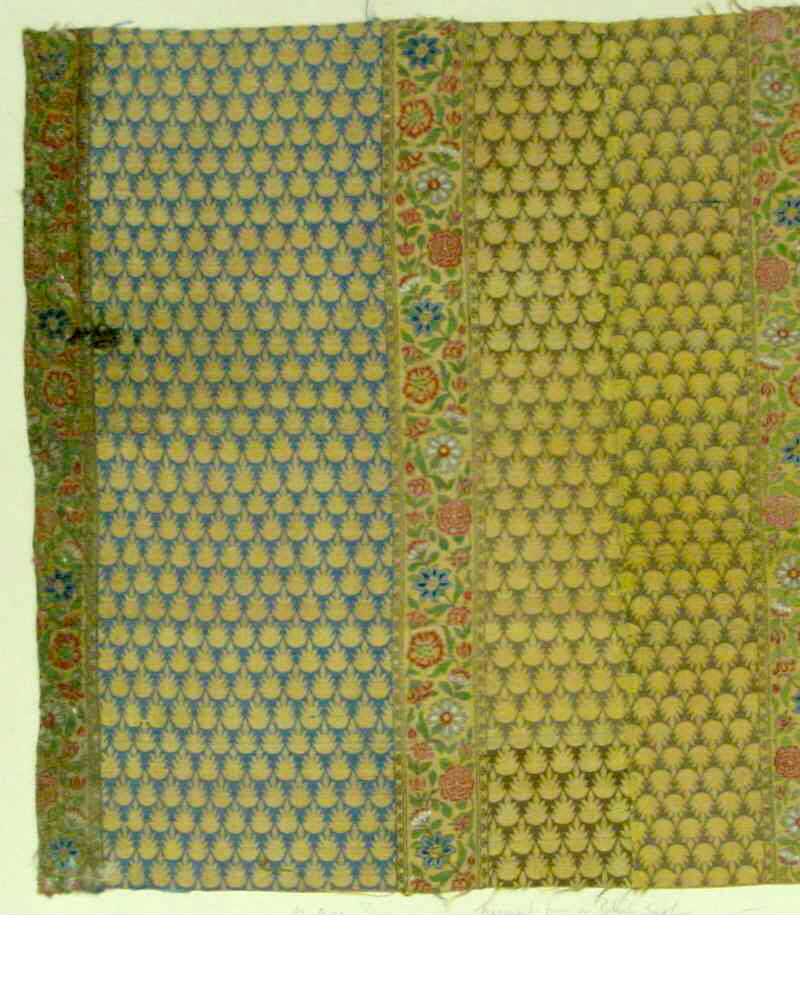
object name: textile fragment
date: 1601-1700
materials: metal thread, silk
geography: iran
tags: flowers